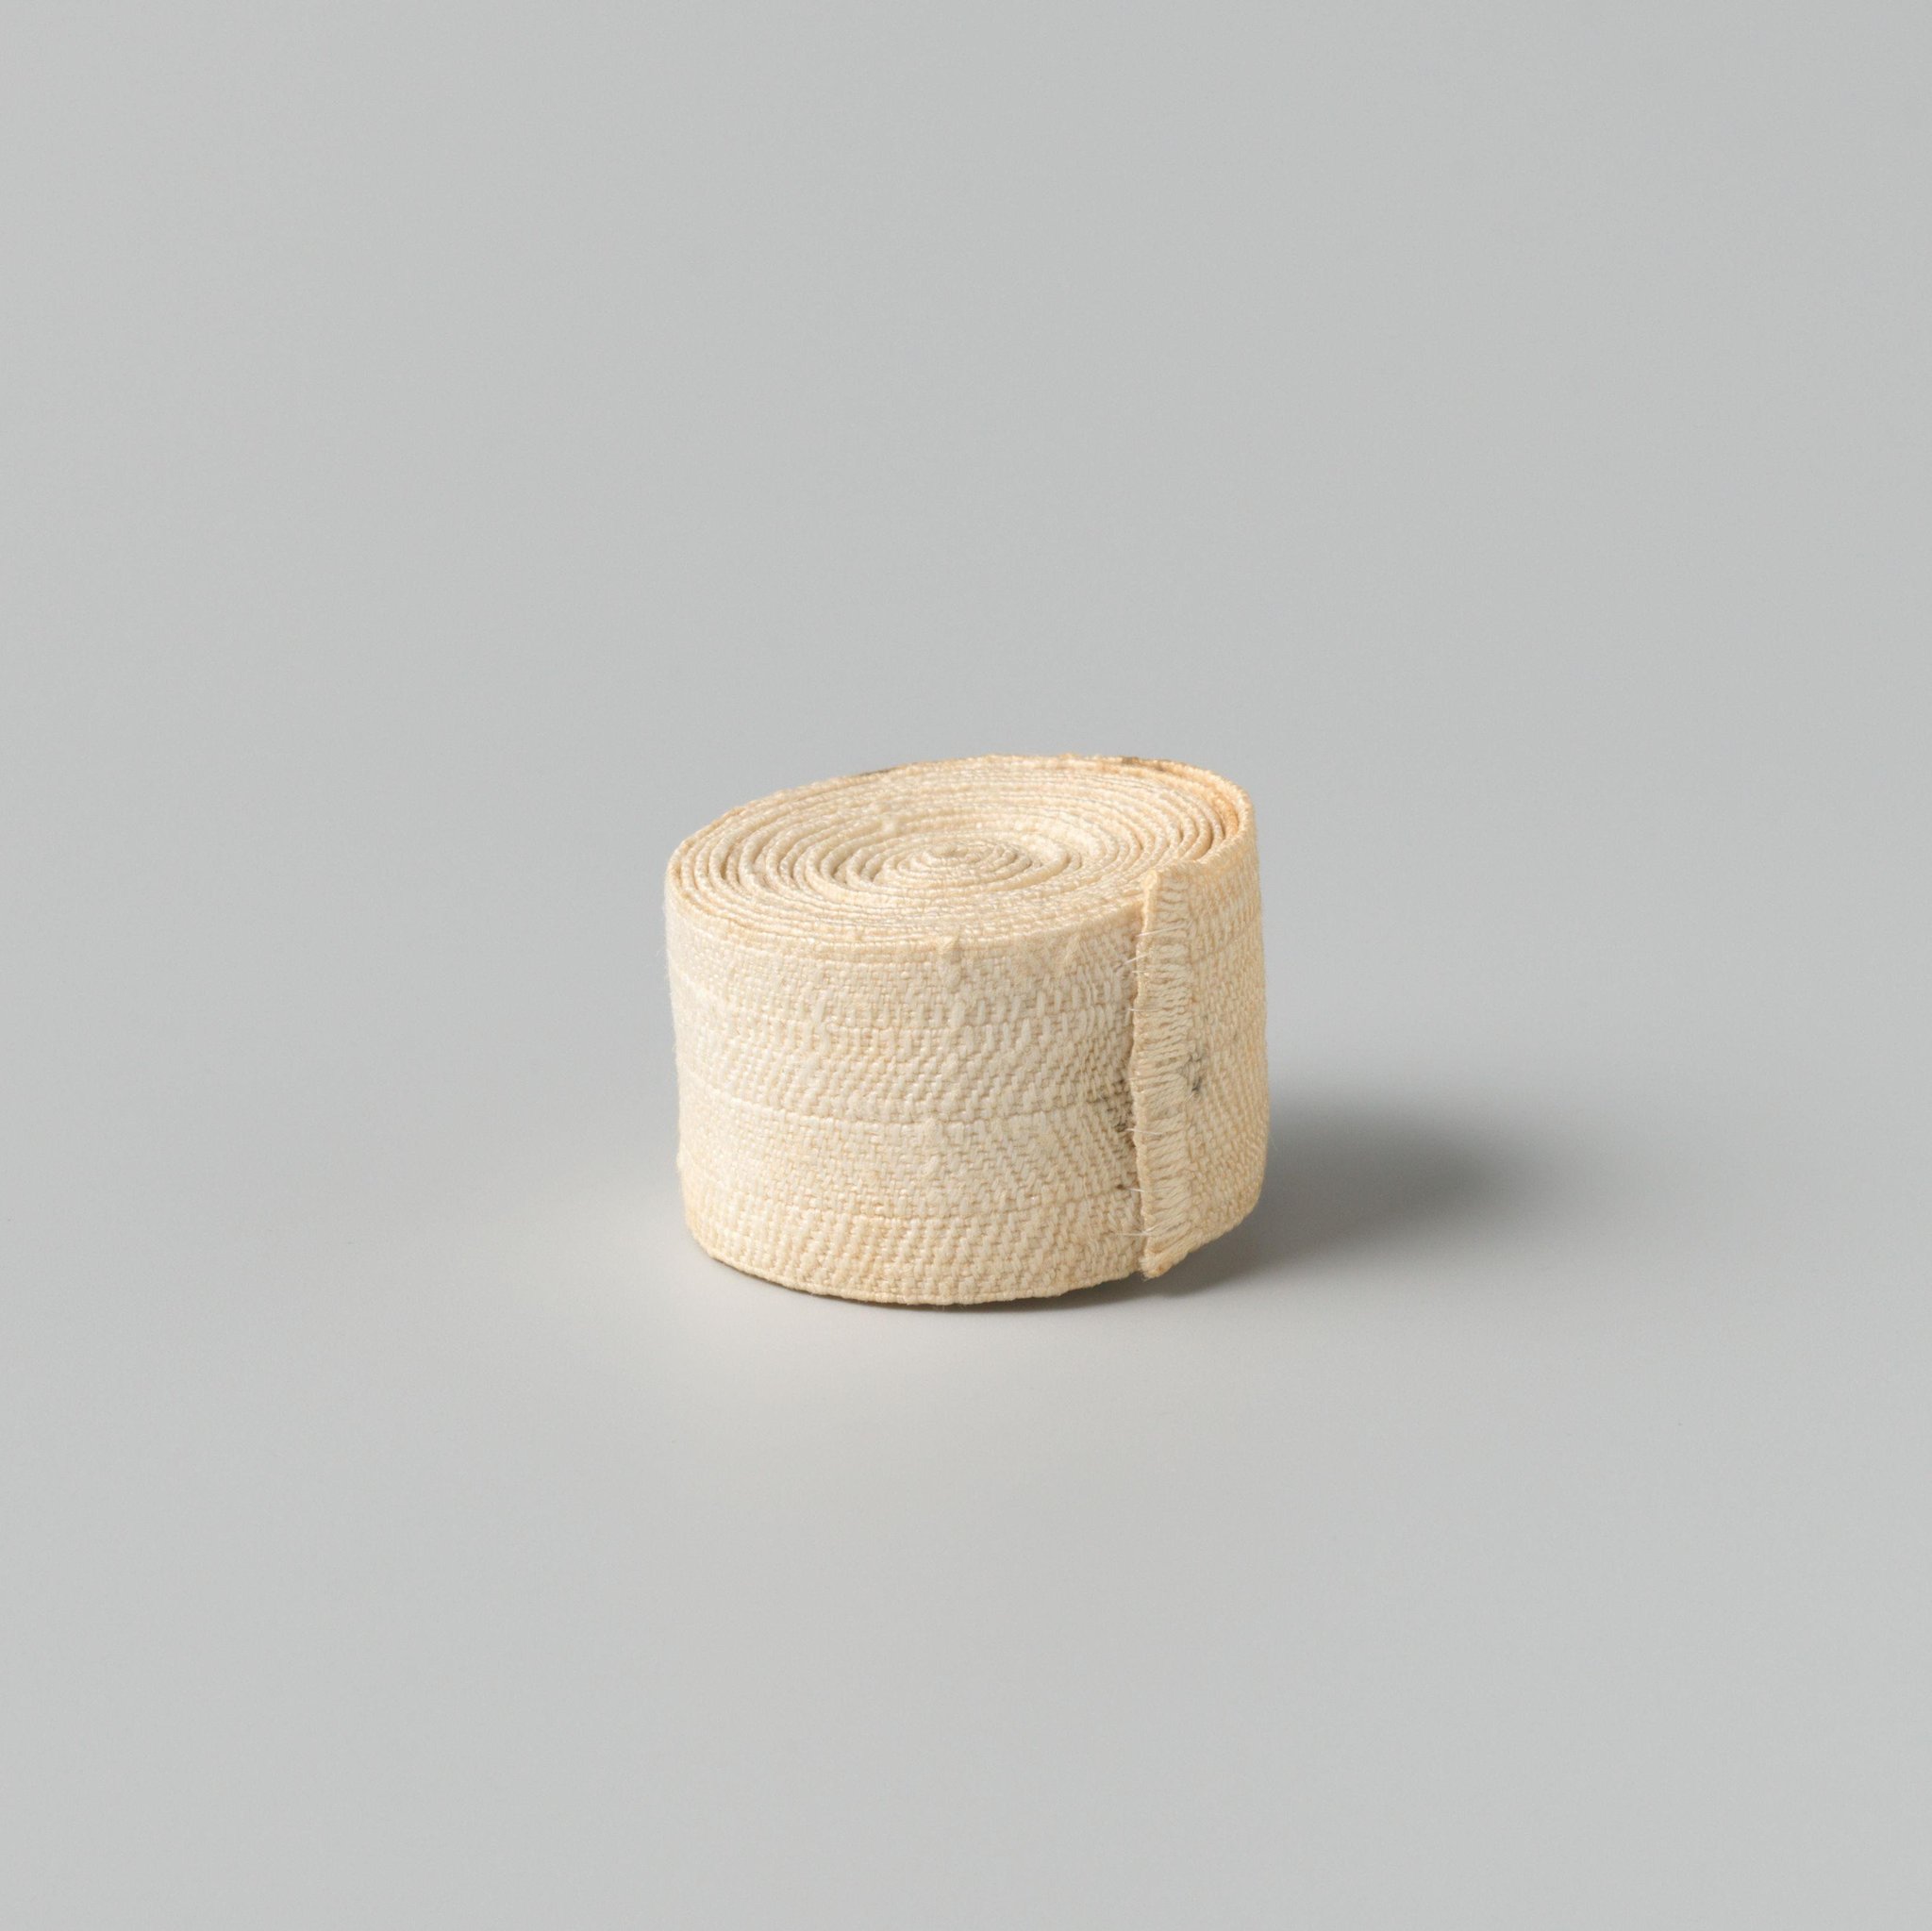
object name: miniature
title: Wikkelband, linnen keper, opgerold en vastgenaaid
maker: Anonymous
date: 1600-1699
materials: linen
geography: netherlands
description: Wikkelband, linnen keper, opgerold en vastgenaaid.